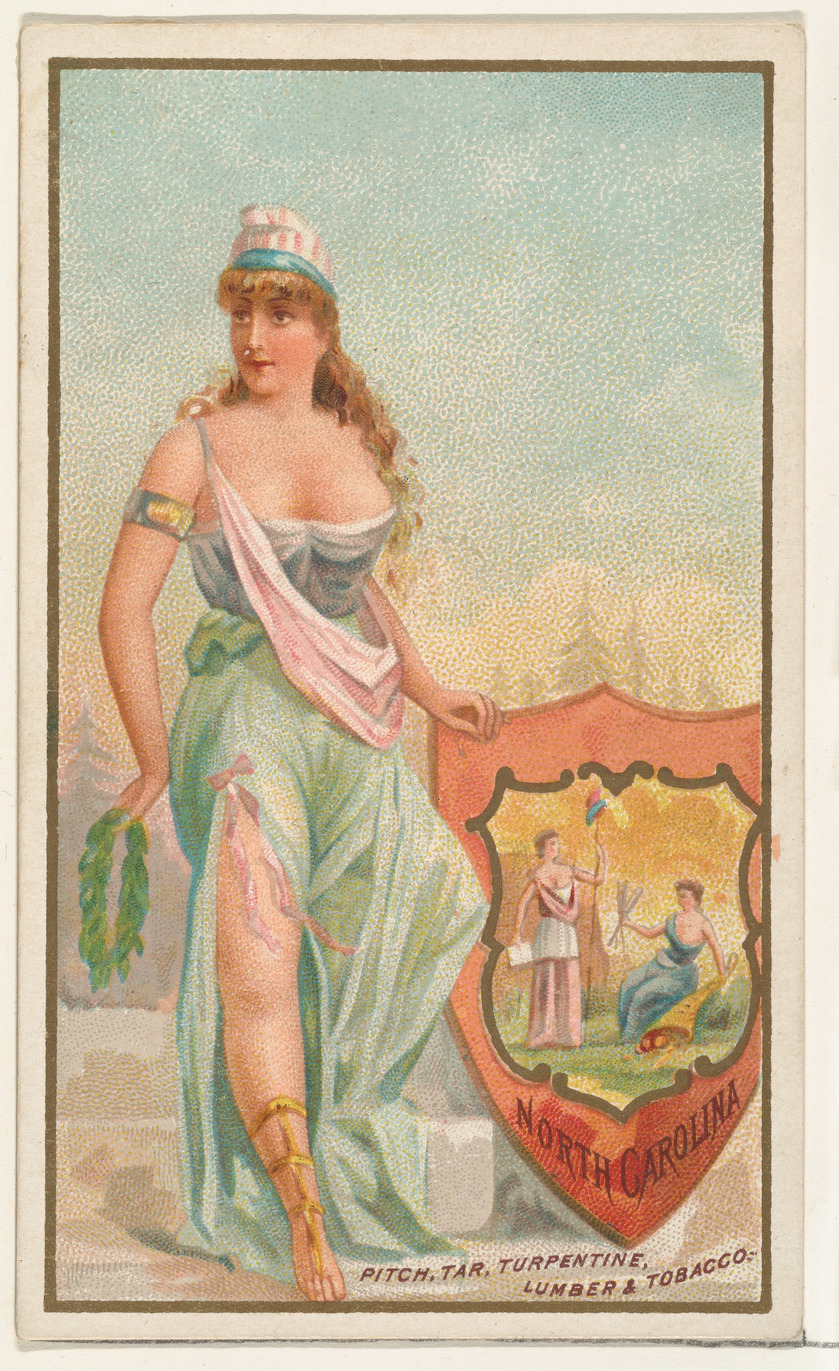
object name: print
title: North Carolina, from the Industries of States series (N117) issued by Duke Sons & Co. to promote Honest Long Cut Tobacco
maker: w. duke, sons & co.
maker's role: publisher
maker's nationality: american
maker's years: 1870-1920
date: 1889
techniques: color lithograph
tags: shields,women